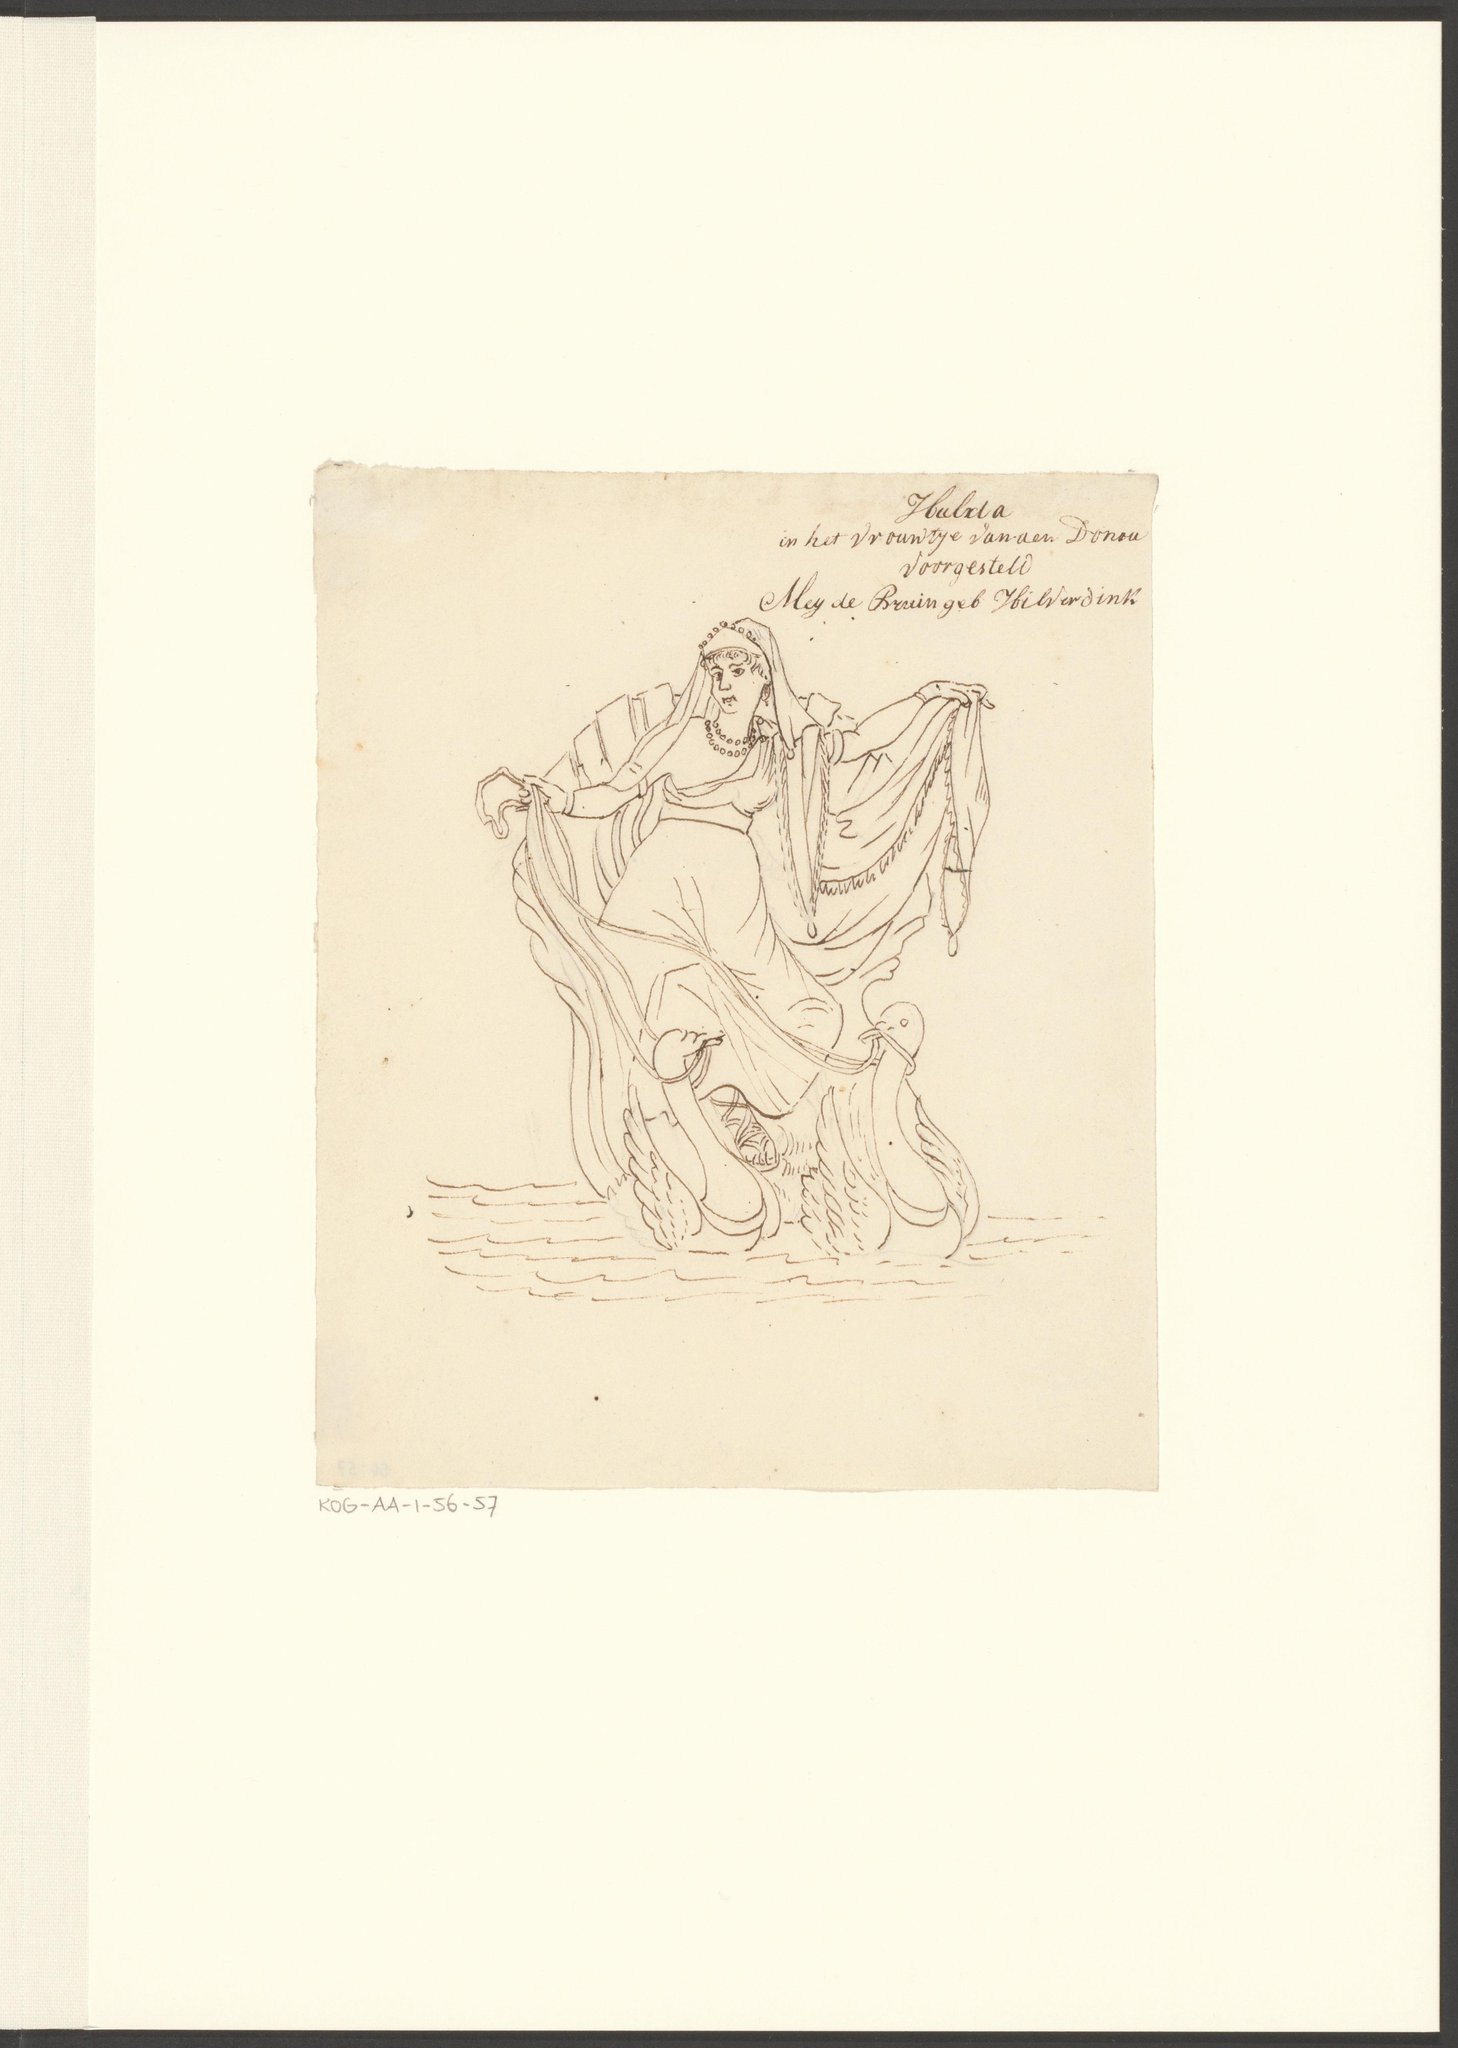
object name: drawing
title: Portret van toneelspeelster Geertruida Jacoba Hilverdink in de rol van Hulda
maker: johannes jelgerhuis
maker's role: draughtsman, painter, print maker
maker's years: 1770-1836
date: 1809-1827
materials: ink, paper, pencil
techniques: pen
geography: amsterdam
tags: geertruida jacoba hilverdink, historical persons - bb - woman, portrait of actor, actress, actor (on the stage), amsterdam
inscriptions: inscription: ‘Hulda / in het vrouwtje van den Donau / voorgesteld / Mey de Bruin geb Hilverdink’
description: Voorbereidende tekening op de prentserie Acteurs en actrices in verschillende rollen van Johannes Jelgerhuis.